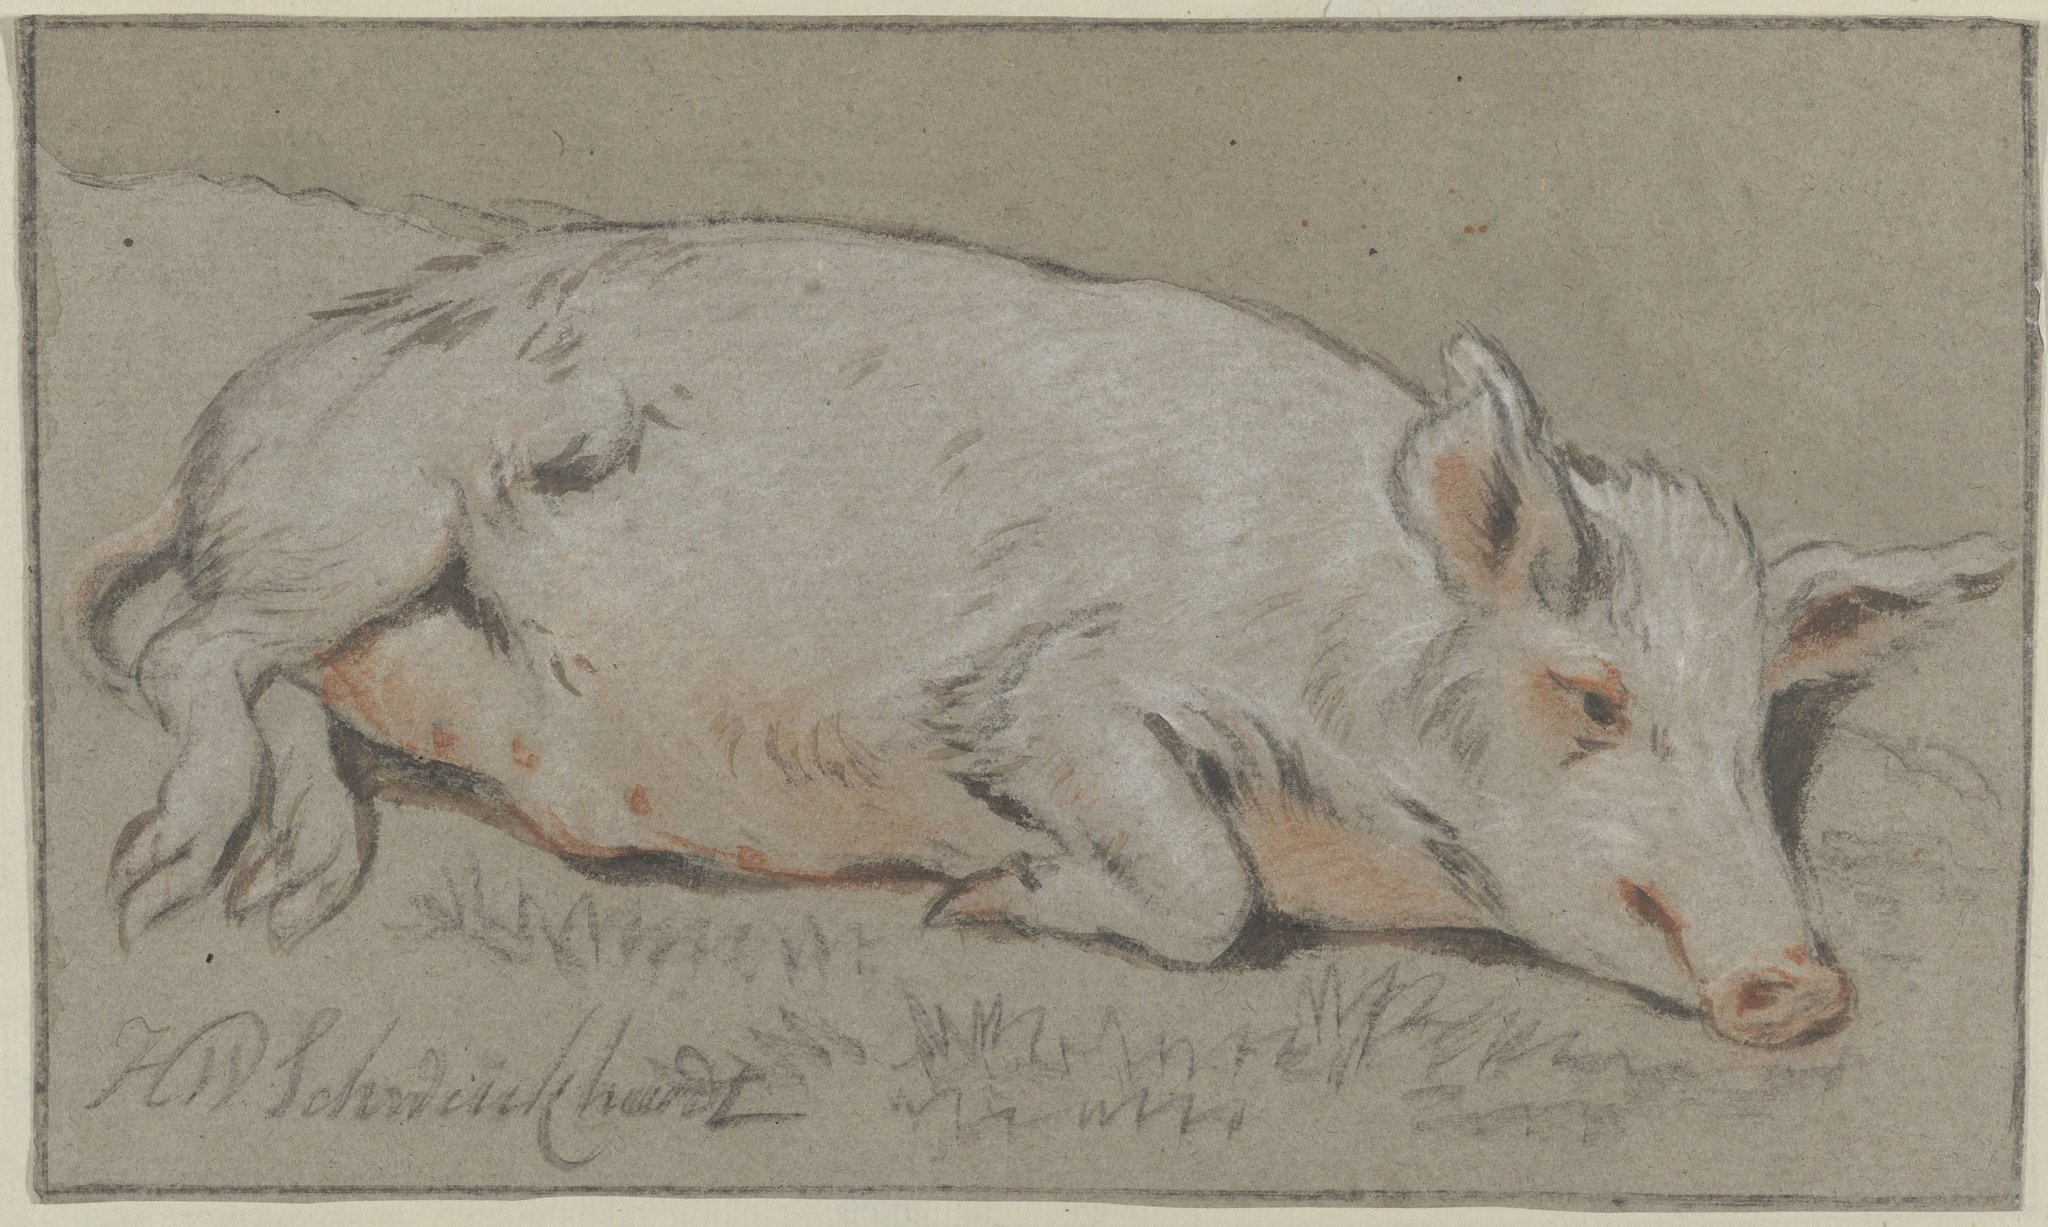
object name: drawing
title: Liggend varken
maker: hendrik willem schweickhardt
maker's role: draughtsman, painter, print maker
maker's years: 1746-1797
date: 1756-1797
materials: chalk, paper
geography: netherlands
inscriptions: signature: ‘HW Schweickhardt’